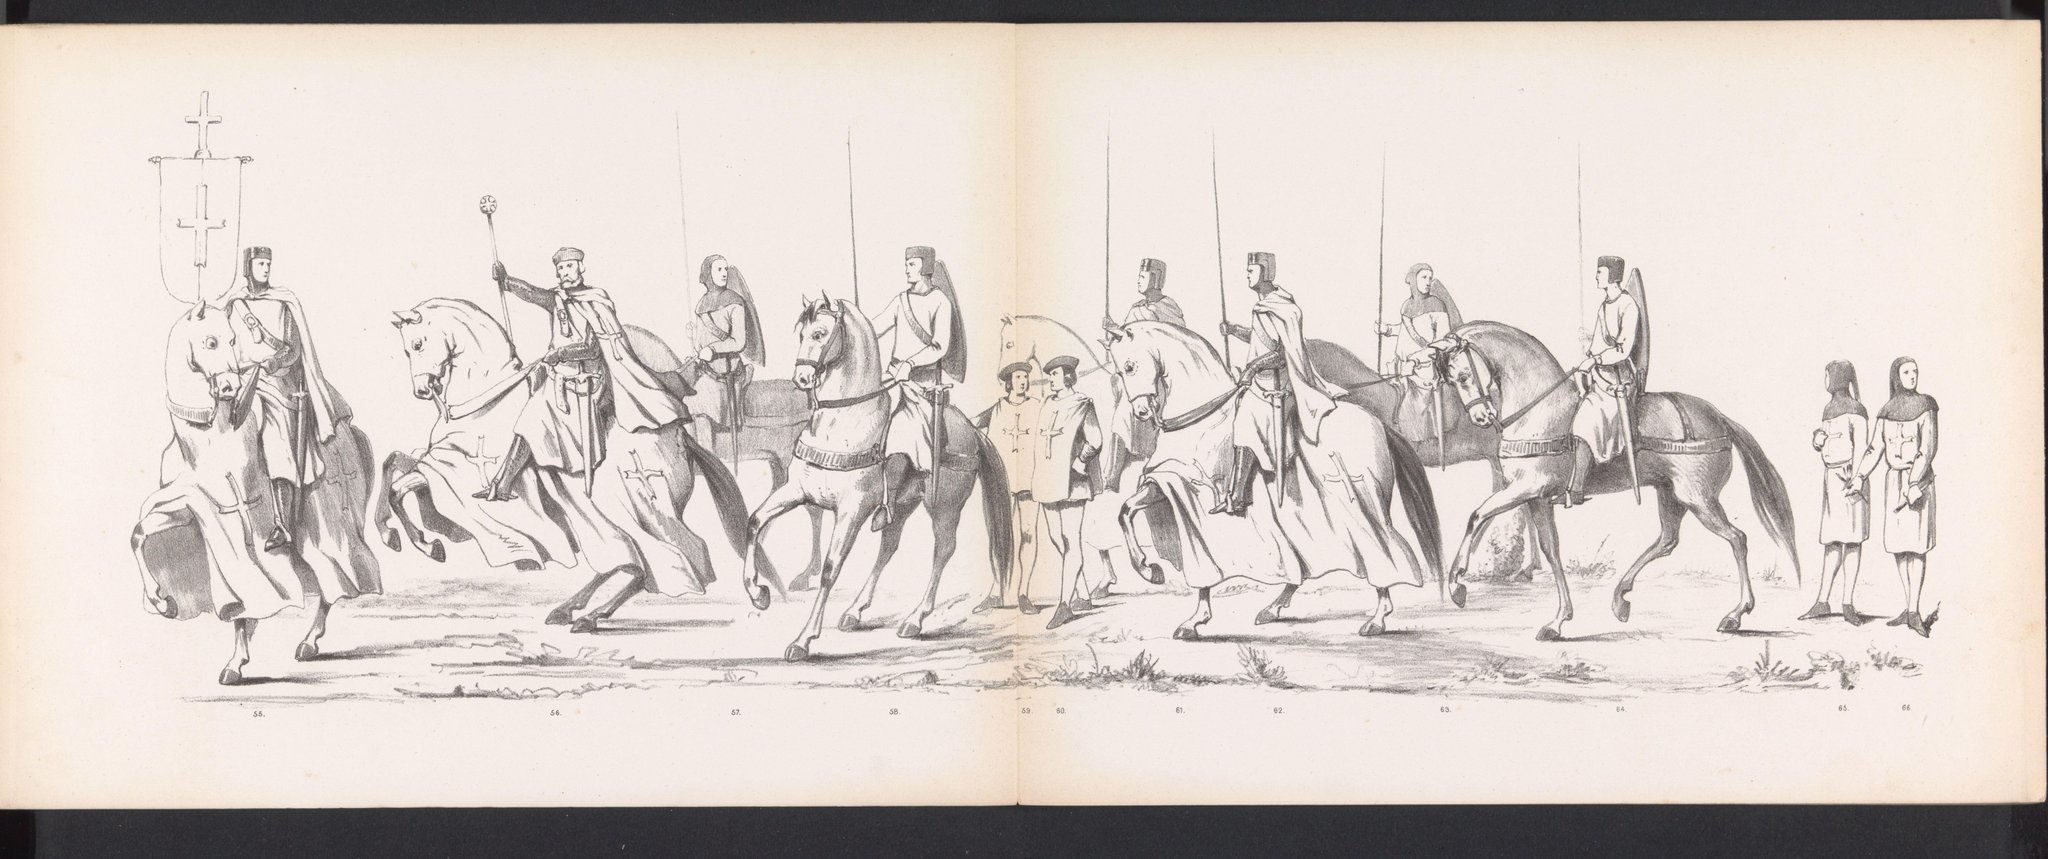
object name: print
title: Gecostumeerde optogt gehouden door de leden van het Leidsche studenten-corps den 6den Junij 1865, ter viering van den 290sten verjaardag der Leidsche Hoogeschool, voorstellende: de intogt der Hollanders binnen Zierikzee onder Jonker Willem, Grave van Oostervant, op den 12den augustus Anno 1304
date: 1865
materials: paper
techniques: lithograph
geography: netherlands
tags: students' pageant, costumes used in pageants, leiden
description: Historische gekostumeerde optocht van de studenten van de Leidse Hogeschool gehouden op 6 juni 1865 ter gelegenheid van het 290-jarig bestaan van de Hogeschool. De optocht verbeeldt de intocht van de Hollanders binnen Zierikzee op 12 augustus 1304. Vijfde plaat met de groepen genummerd 55-66. Onderdeel van de serie van 16 aaneen geplakte bladen.